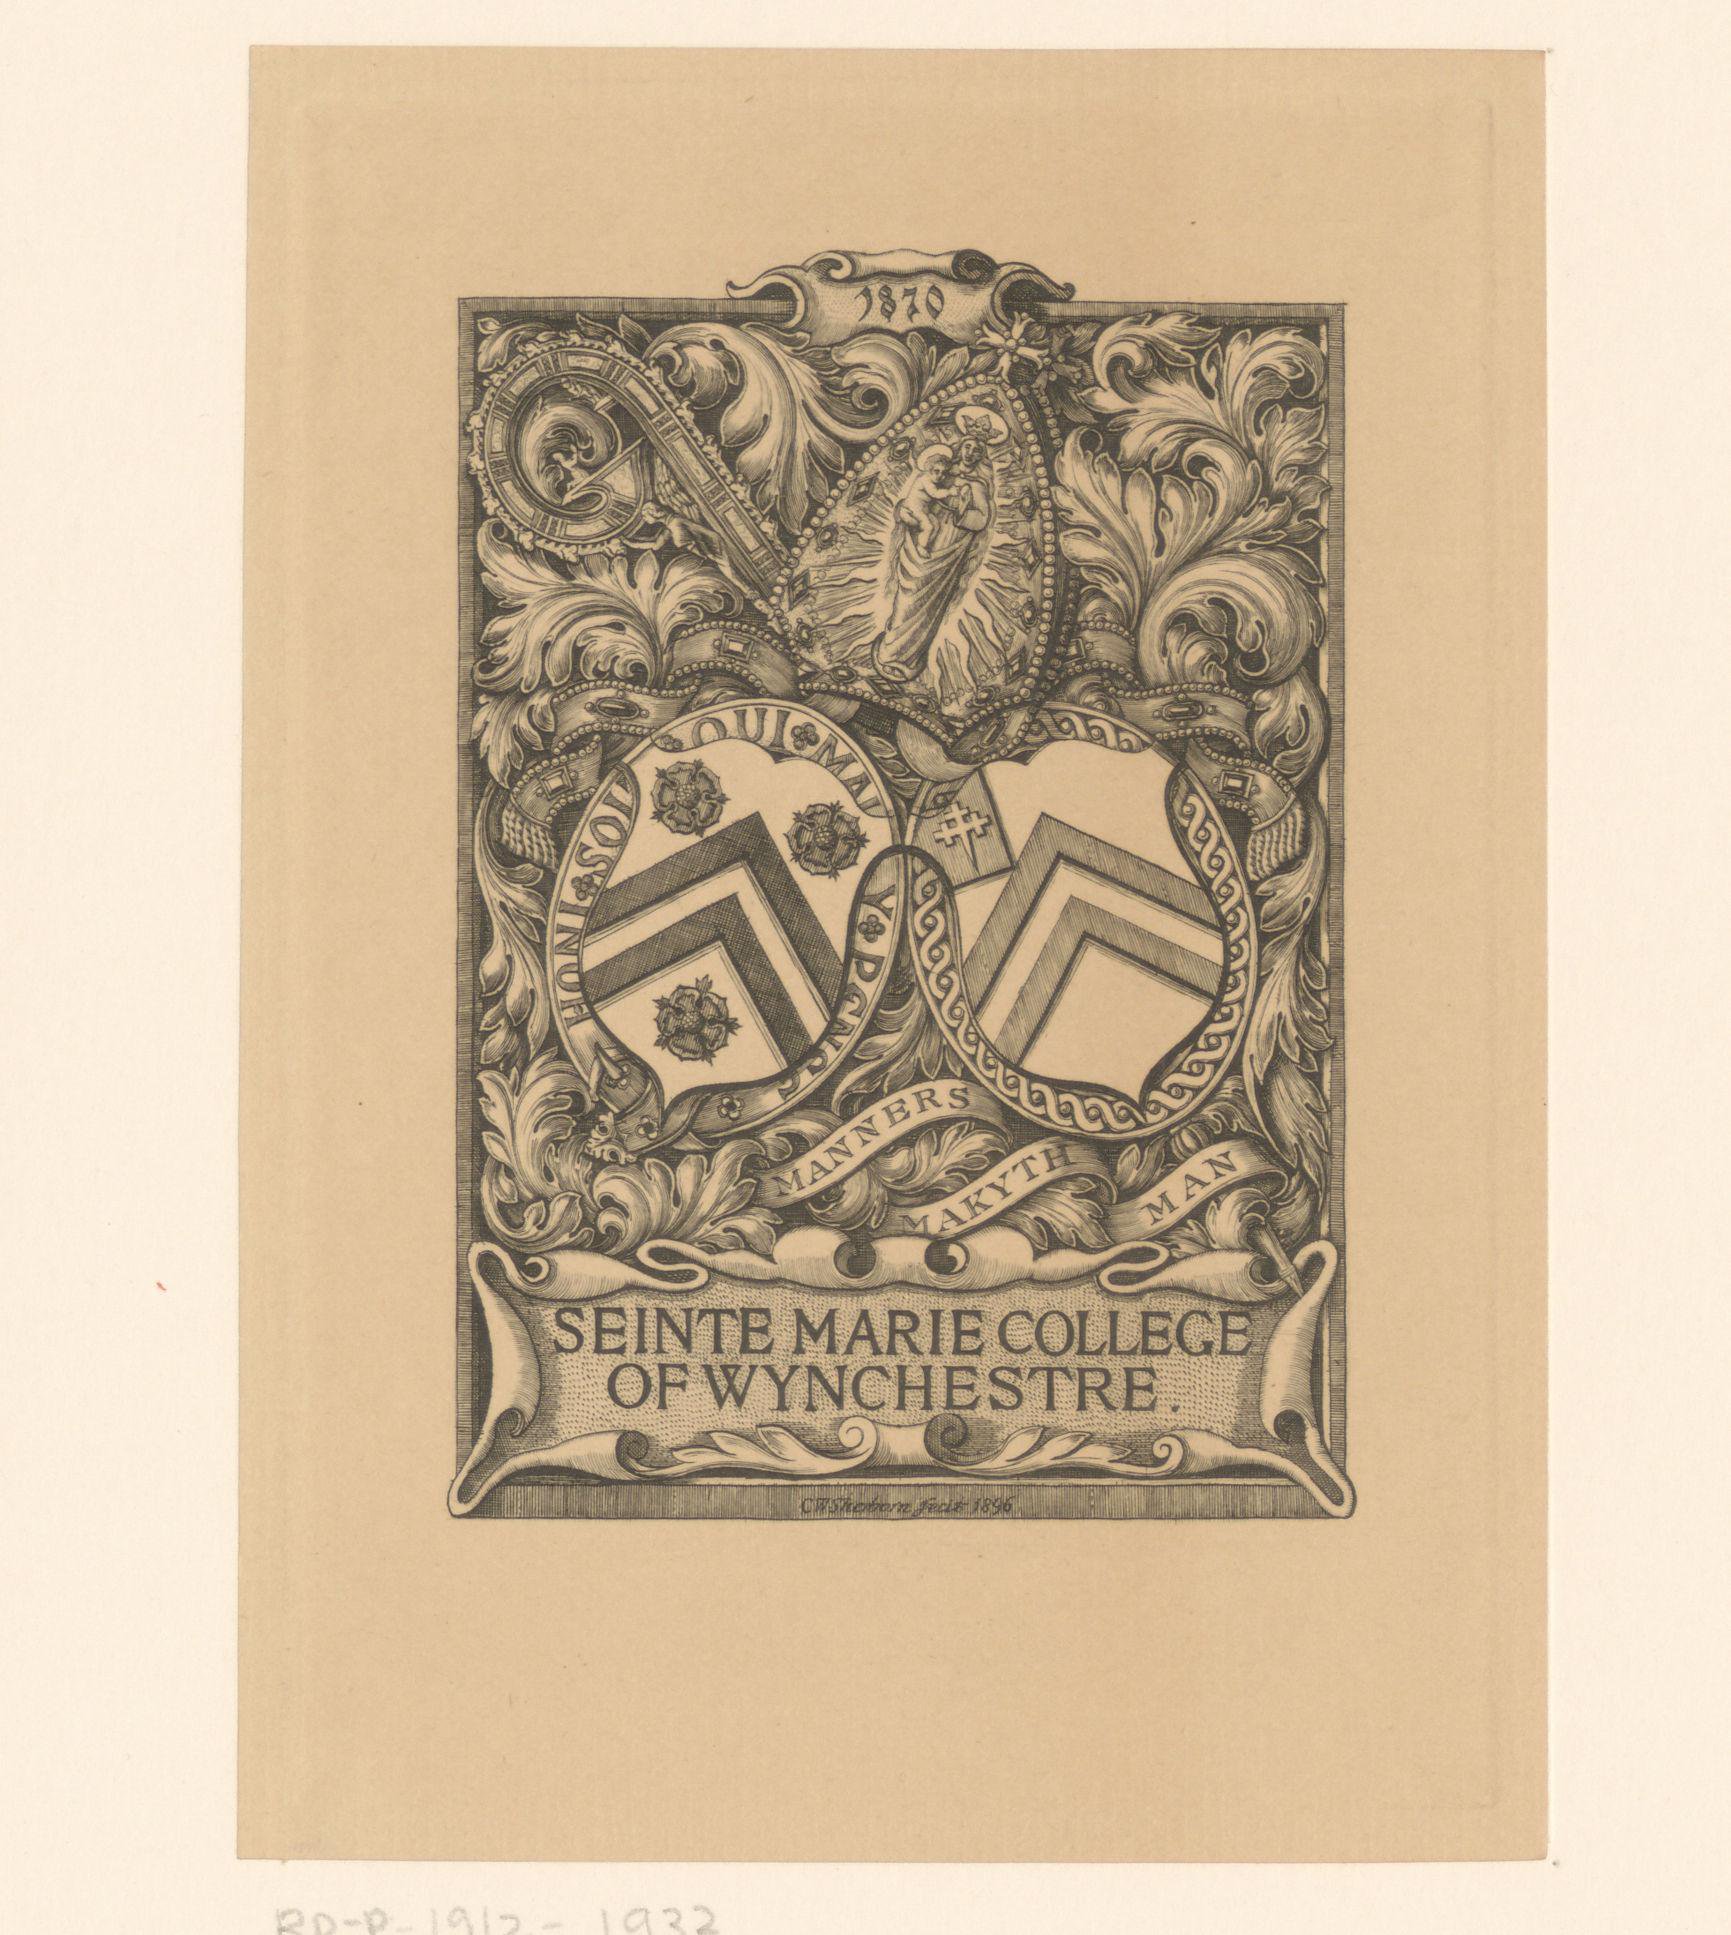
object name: bookplate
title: Ex libris van het Winchester College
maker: charles william sherborn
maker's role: print maker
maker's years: 1831-1912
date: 1896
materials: paper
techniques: engraving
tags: madonna: i.e. mary with the christ-child, foliage ~ ornament, armorial bearing, heraldry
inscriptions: collector's mark: Lugt 2228